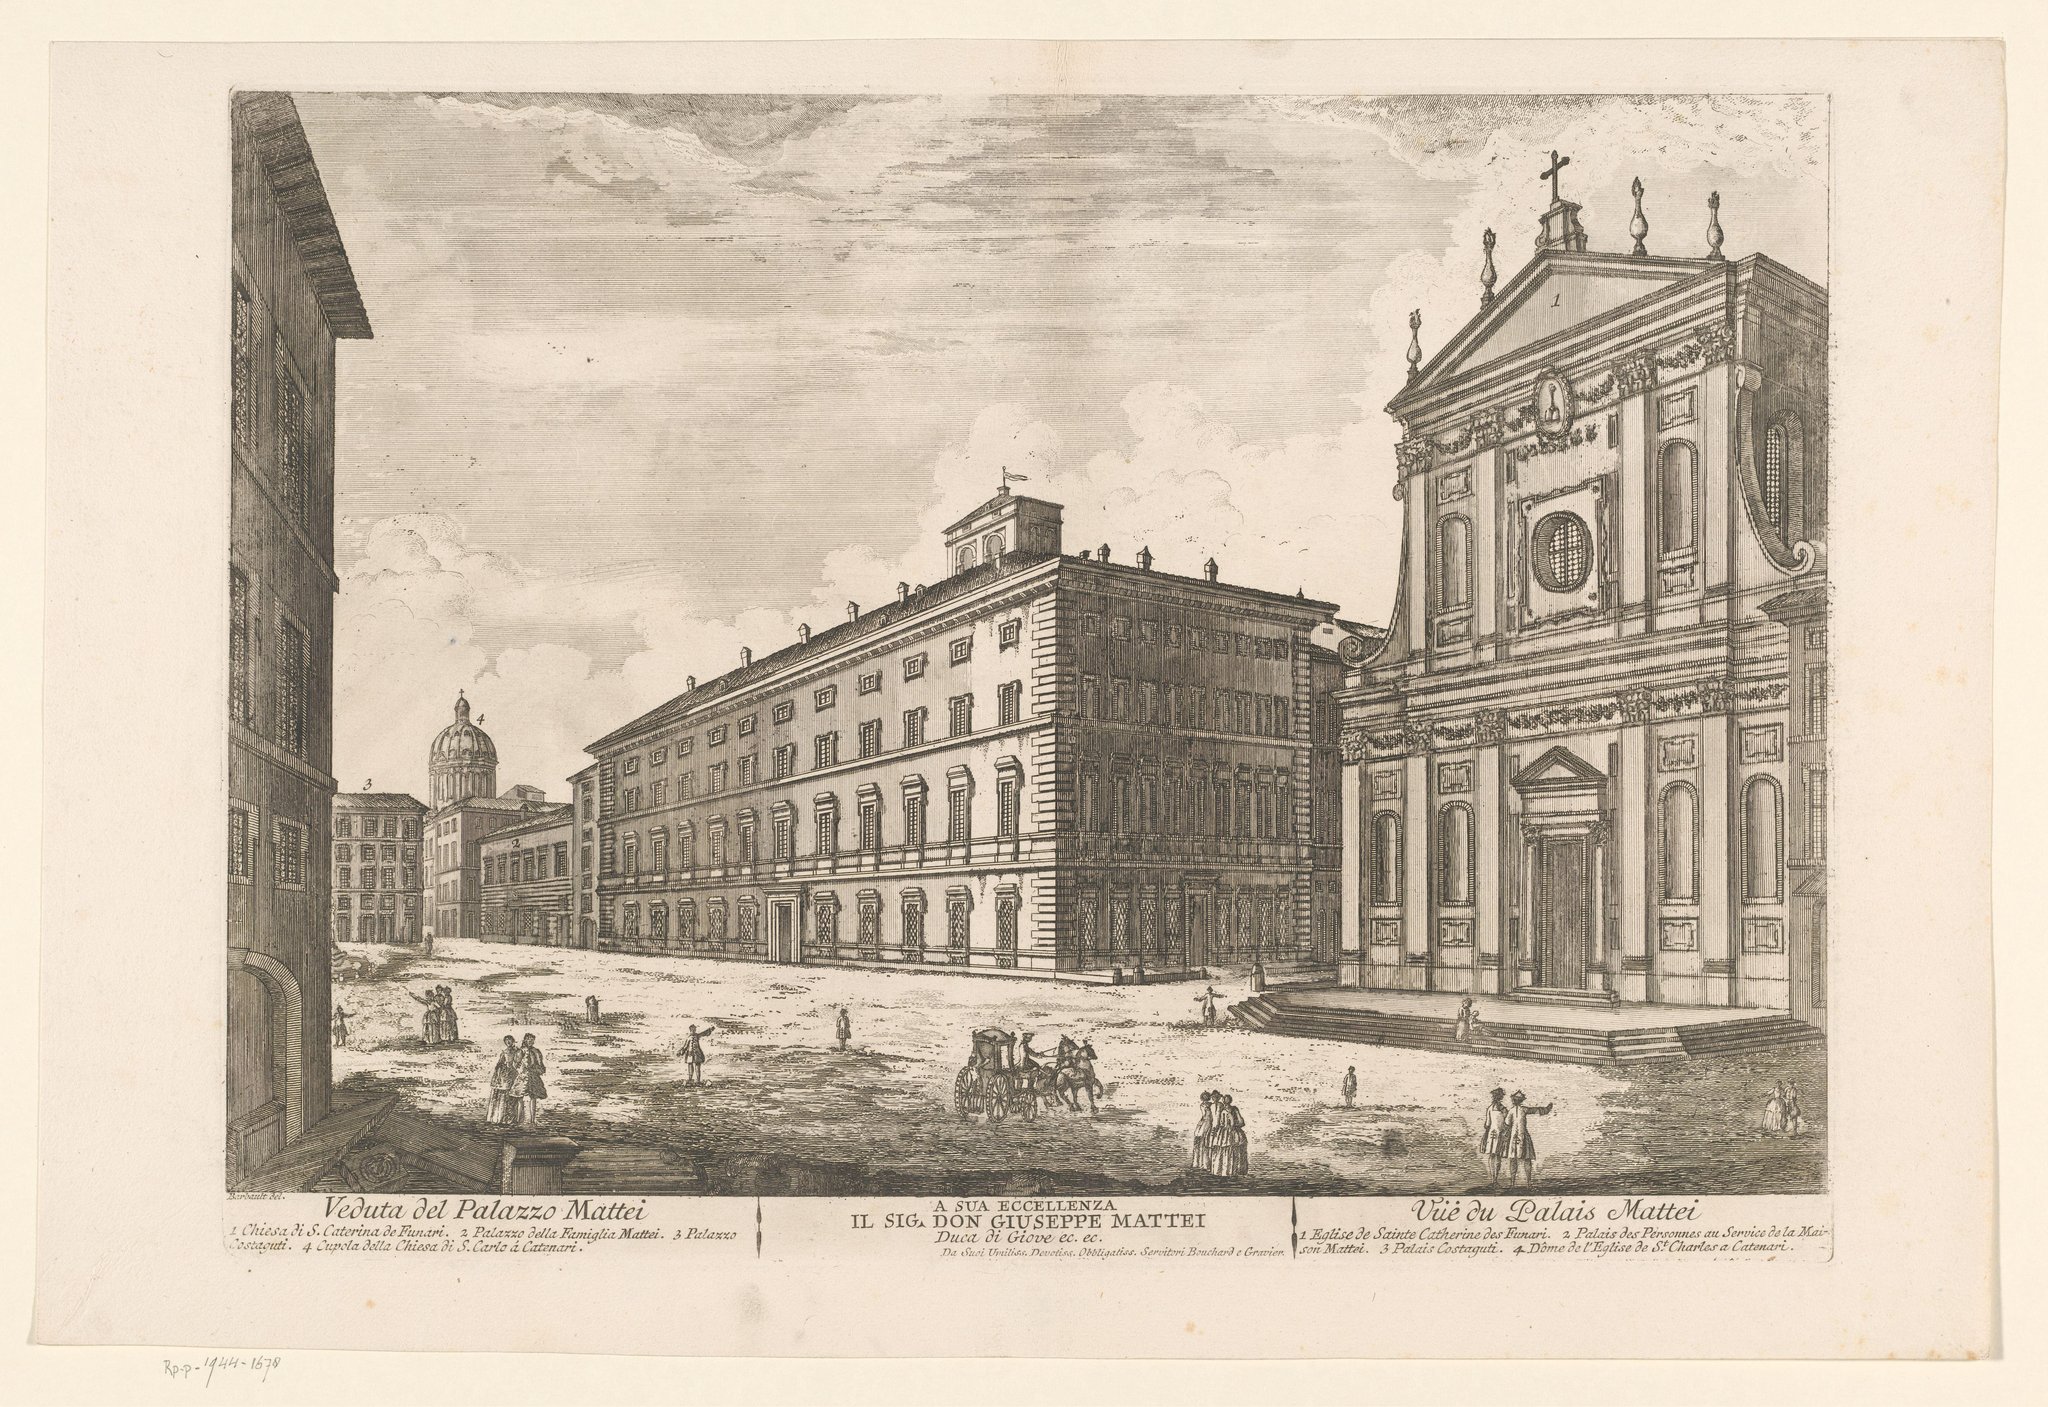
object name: print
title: Veduta del Palazzo Mattei / Vuë du Palais Mattei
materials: paper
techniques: engraving, etching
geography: rome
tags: palace, church (exterior)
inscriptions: collector's mark: Lugt 2228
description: Gezicht op het Palazzo Mattei, met rechts de Santa Caterina dei Funari.